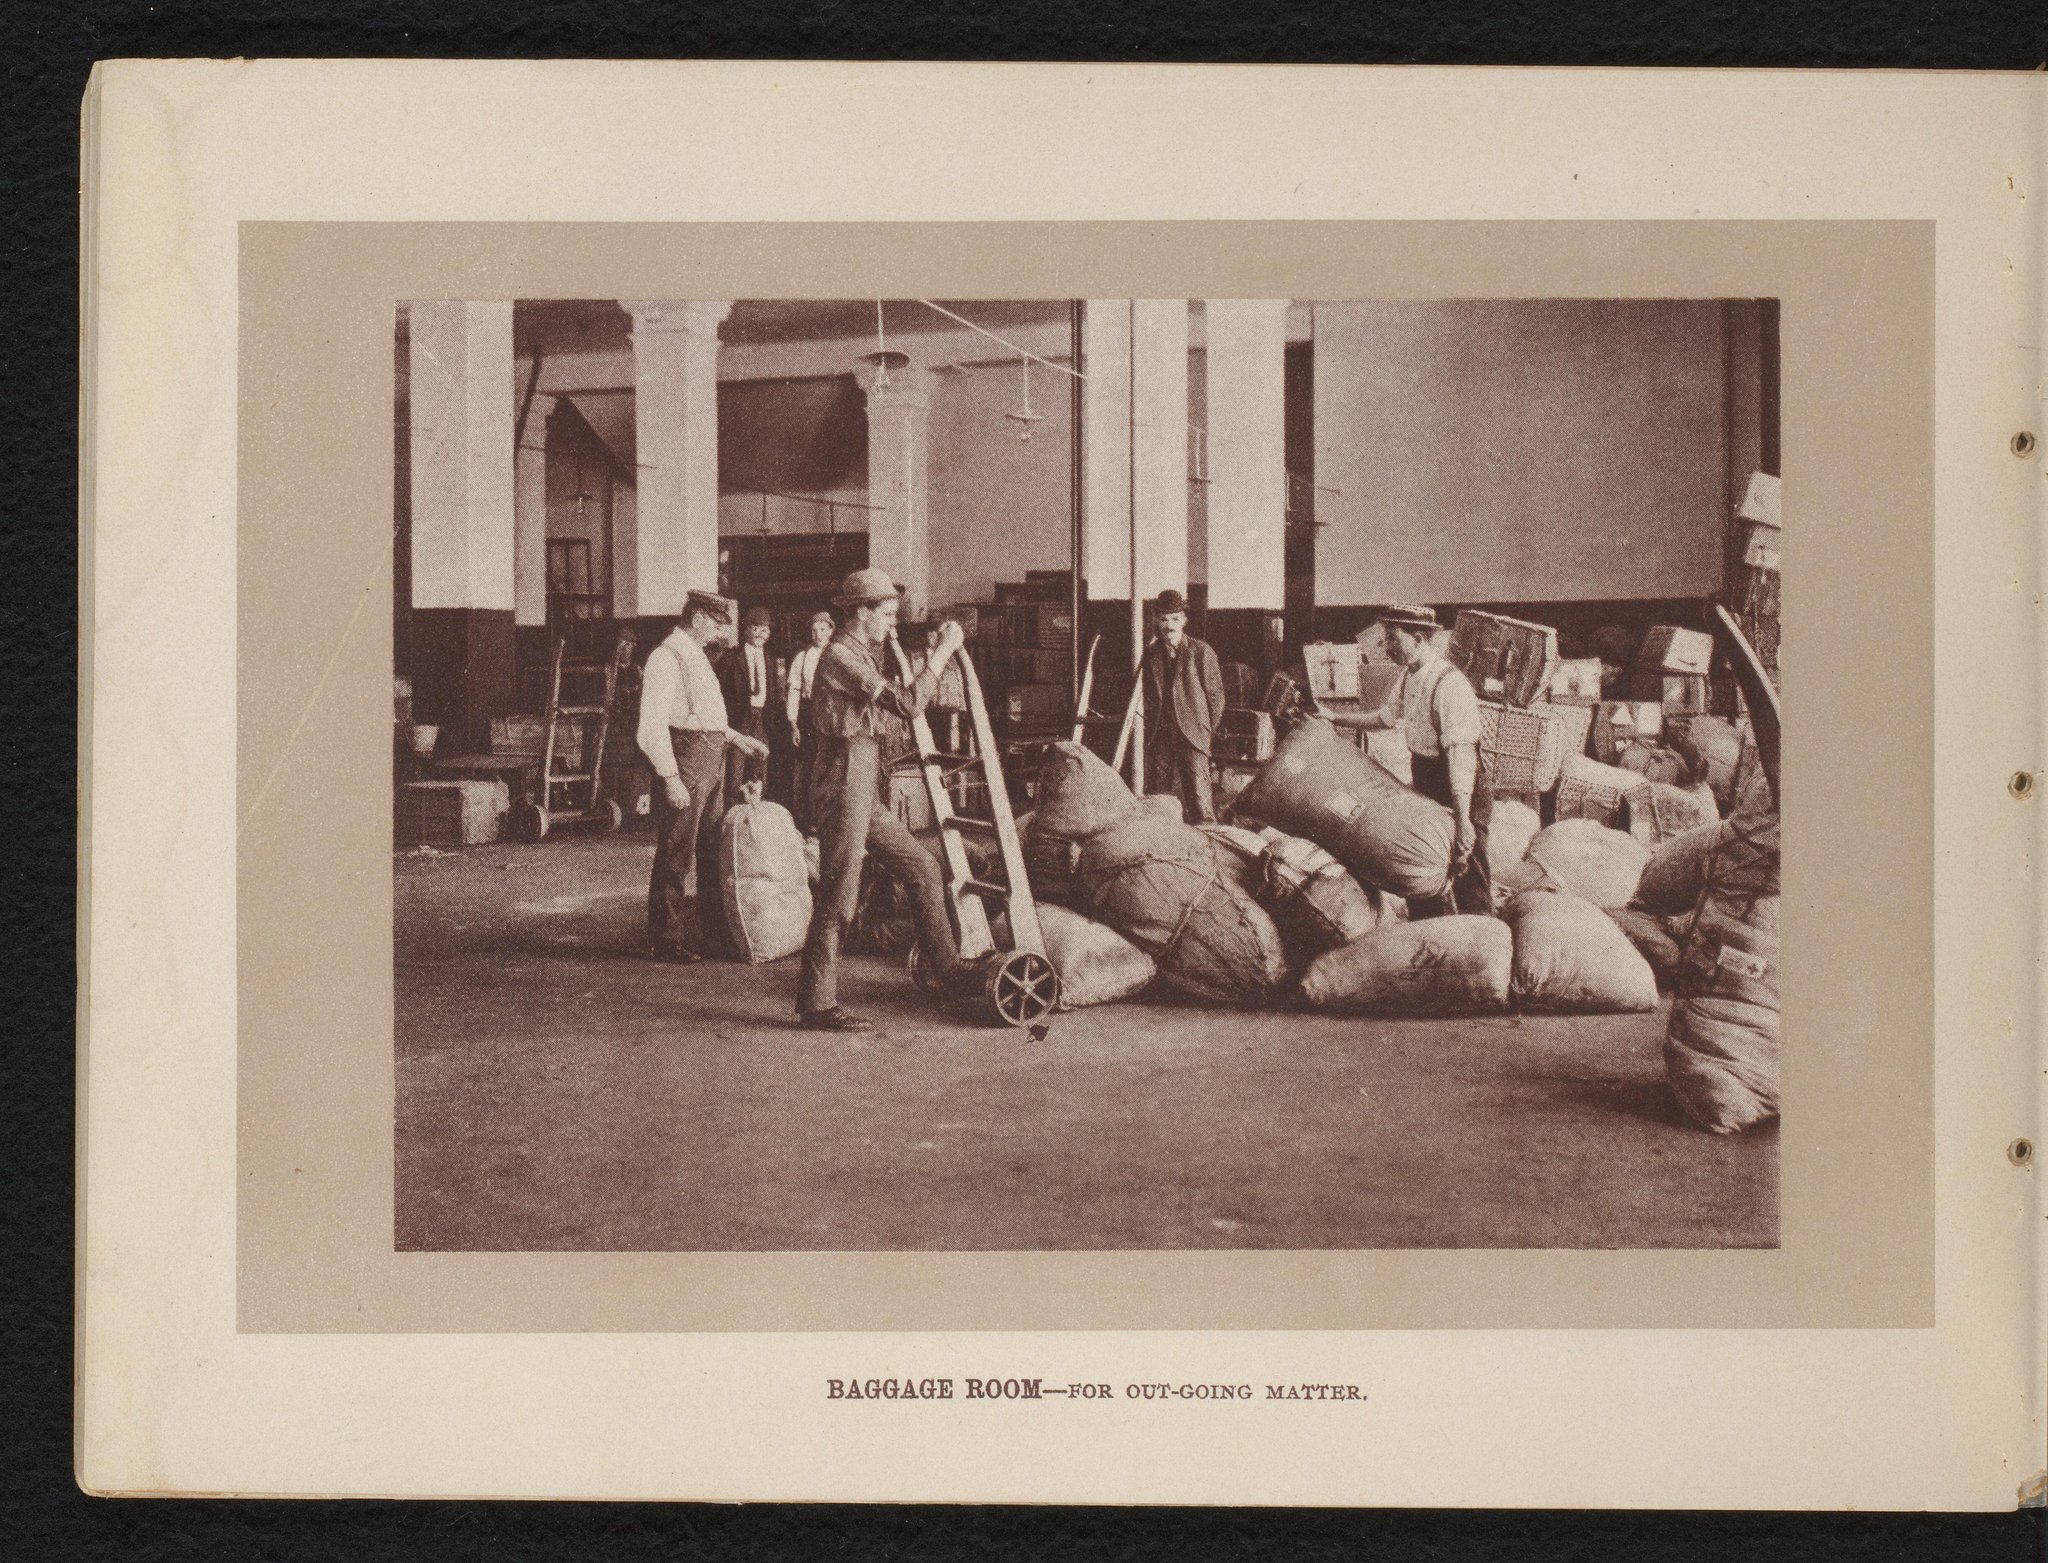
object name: photomechanical print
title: Baggage room - for outgoing matter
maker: Anonymous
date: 1897-1902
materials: paper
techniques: autotype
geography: new york city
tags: luggage, travel requisites, (descendants of) european emigrants to america, historical persons not known by name, new york (city)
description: Prent op negenentwintigste ongenummerde pagina.